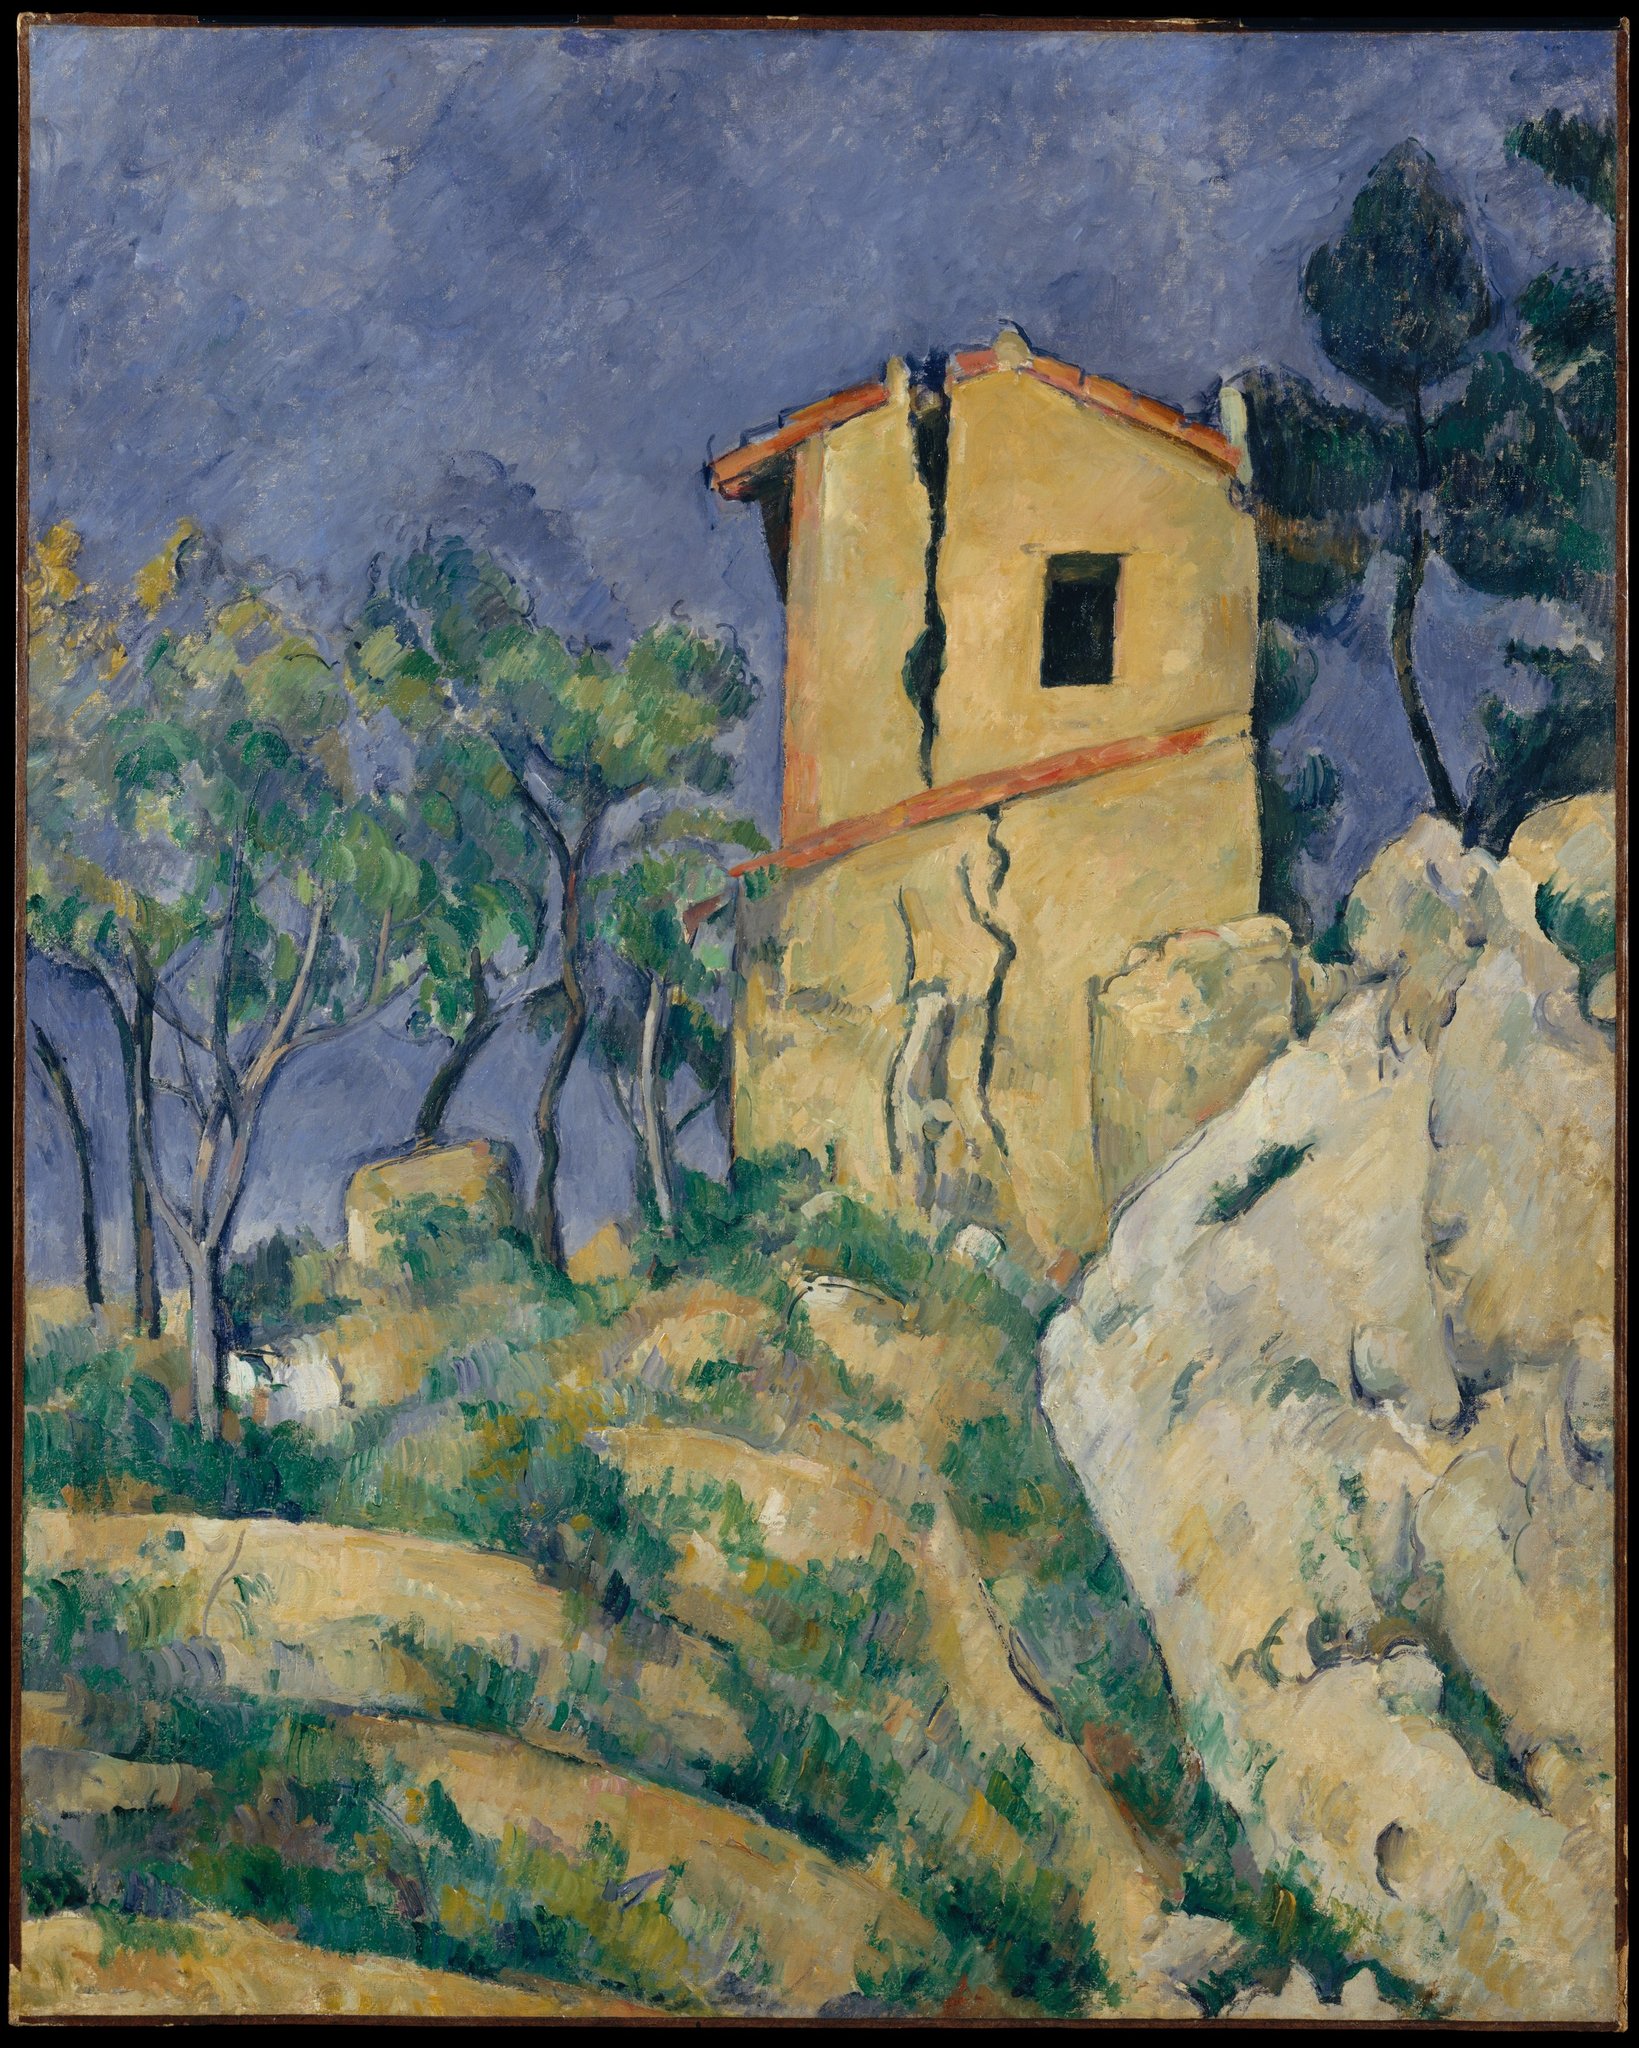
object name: painting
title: The House with the Cracked Walls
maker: paul cézanne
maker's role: artist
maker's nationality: french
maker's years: 1839-1906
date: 1892-1894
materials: canvas, oil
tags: houses,landscapes